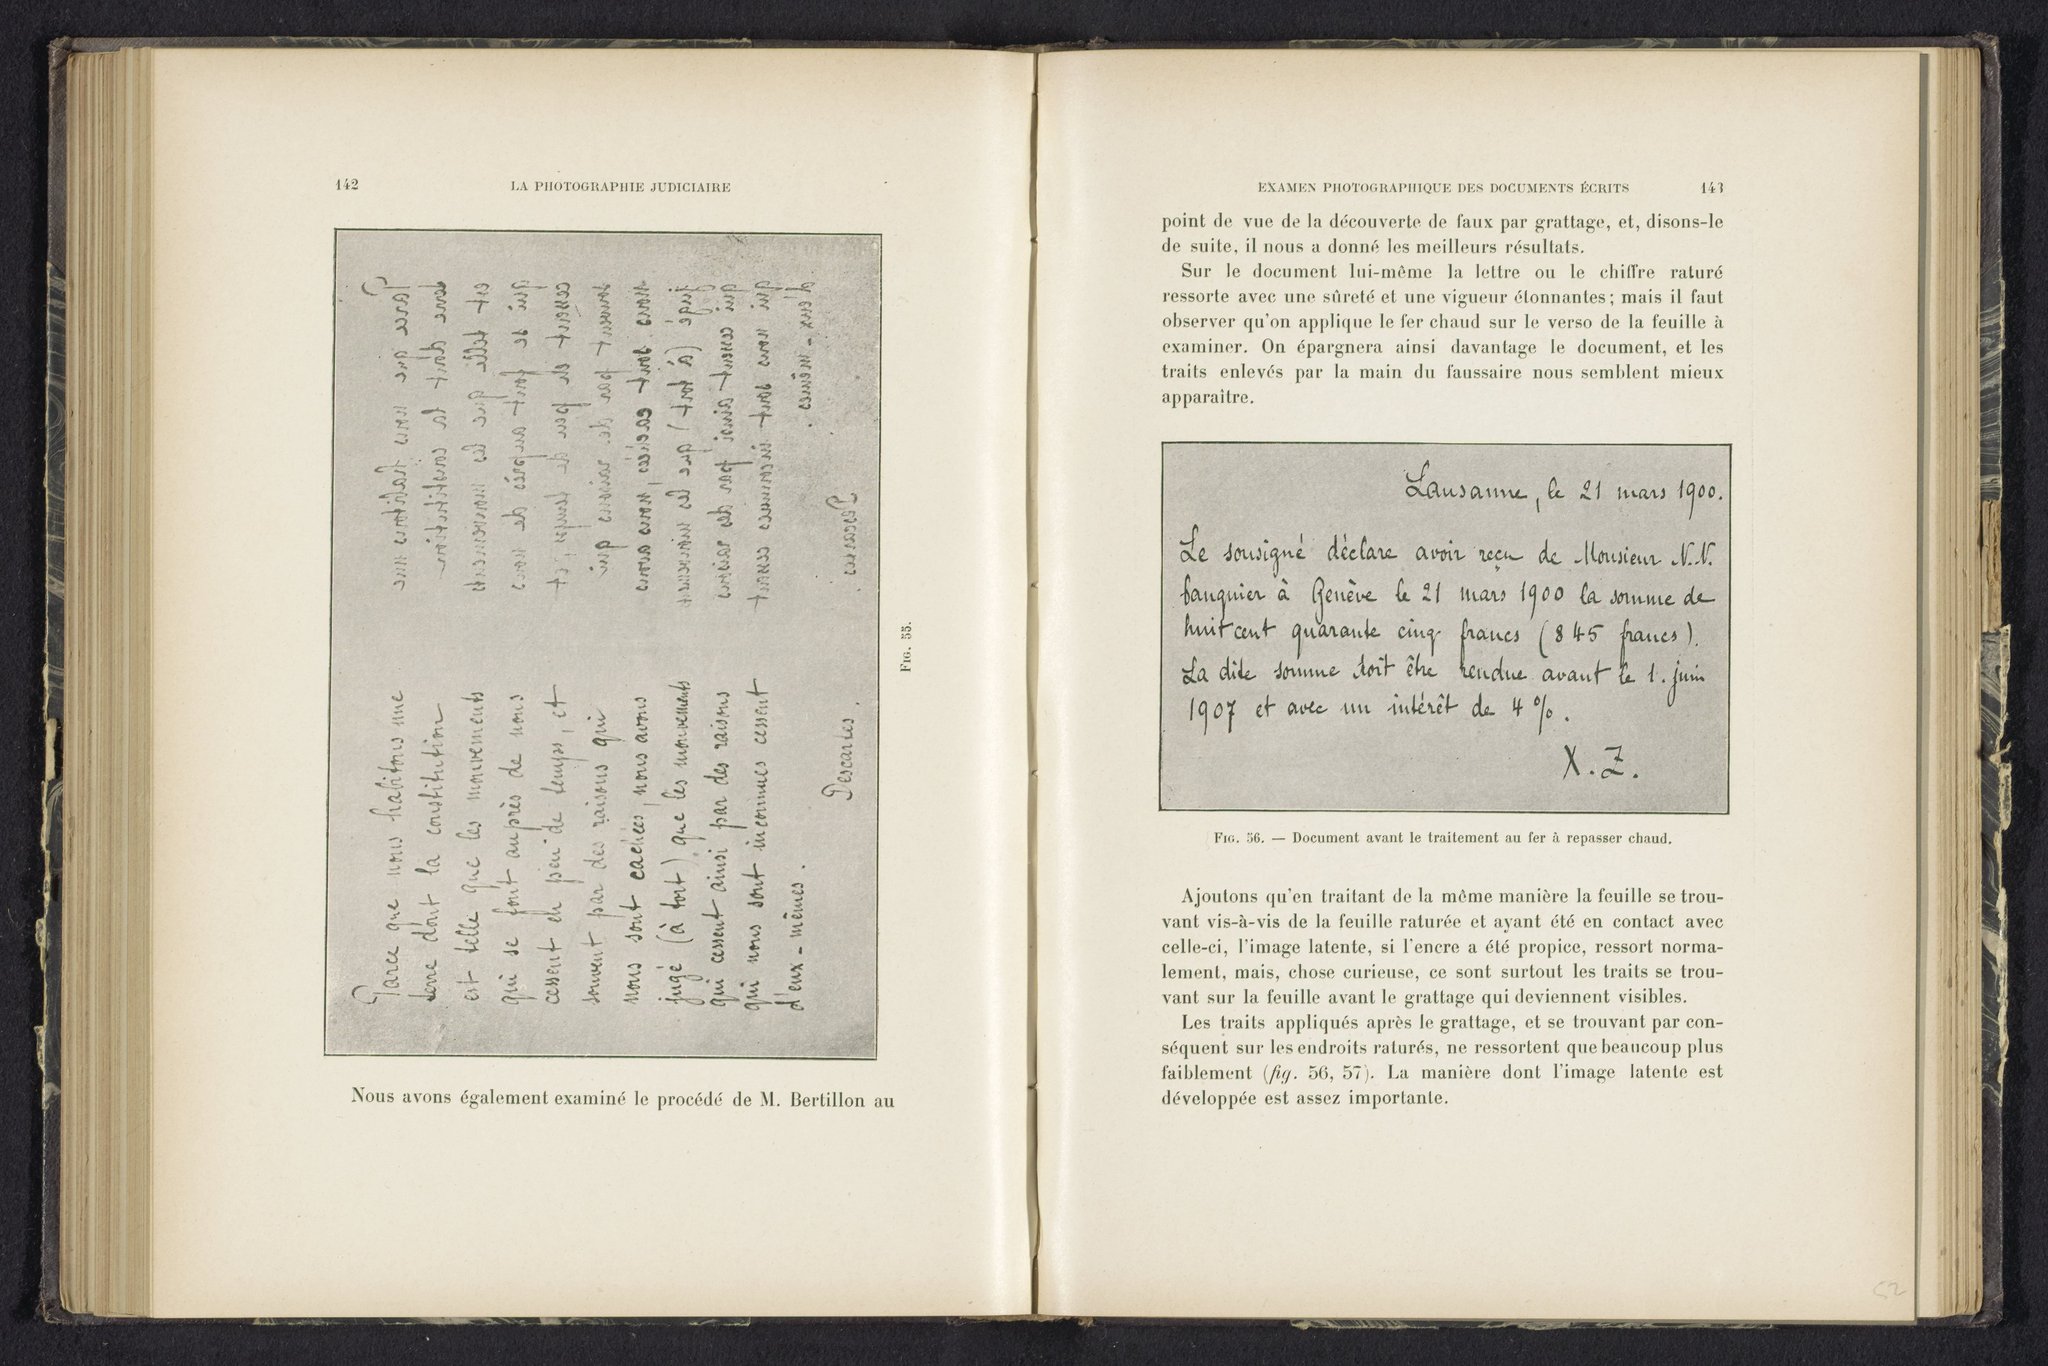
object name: photomechanical print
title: Handgeschreven brief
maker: Anonymous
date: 1893-1903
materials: paper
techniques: autotype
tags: handwriting, written text, letter, envelope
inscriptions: number: ‘Fig. 56.’